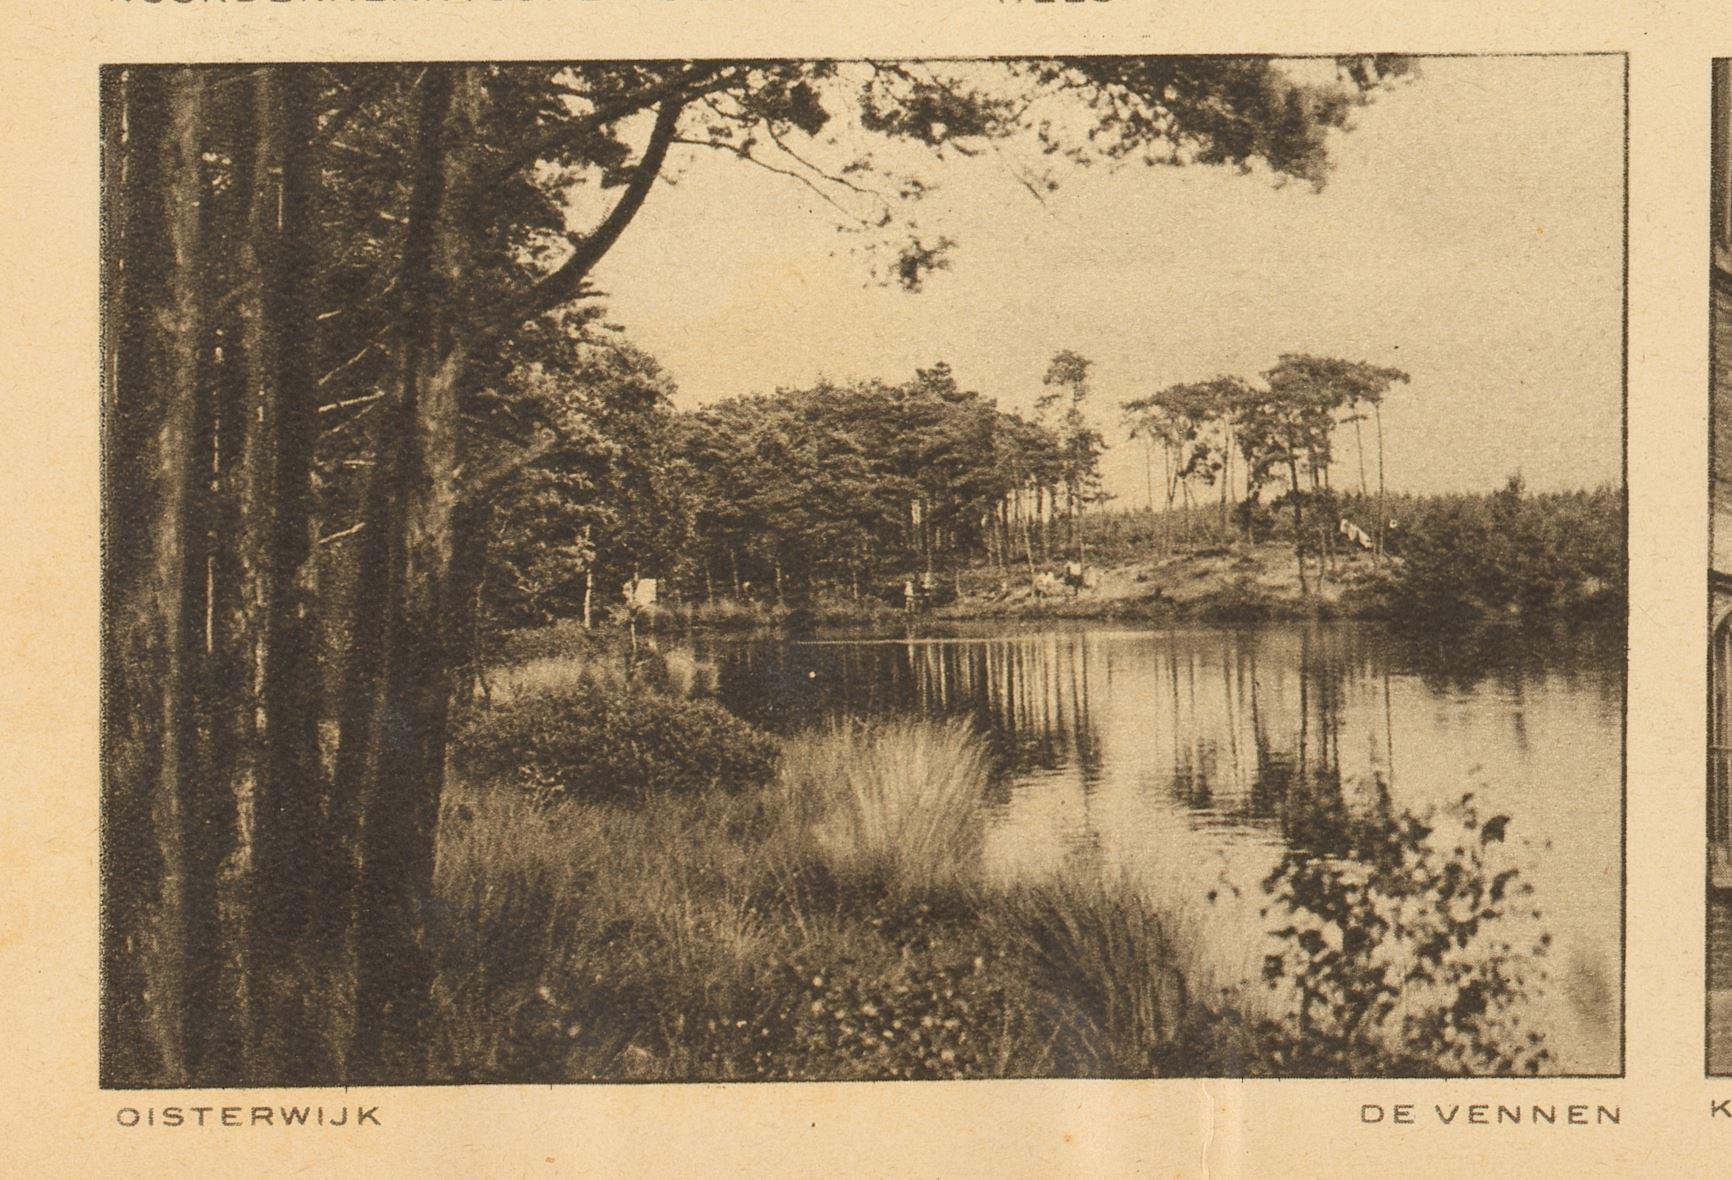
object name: album leaf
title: Oisterwijk - De Vennen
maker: Anonymous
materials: paper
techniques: rotogravure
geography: oisterwijk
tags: fen, du. 'ven'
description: Deze prent maakt deel uit van een album.